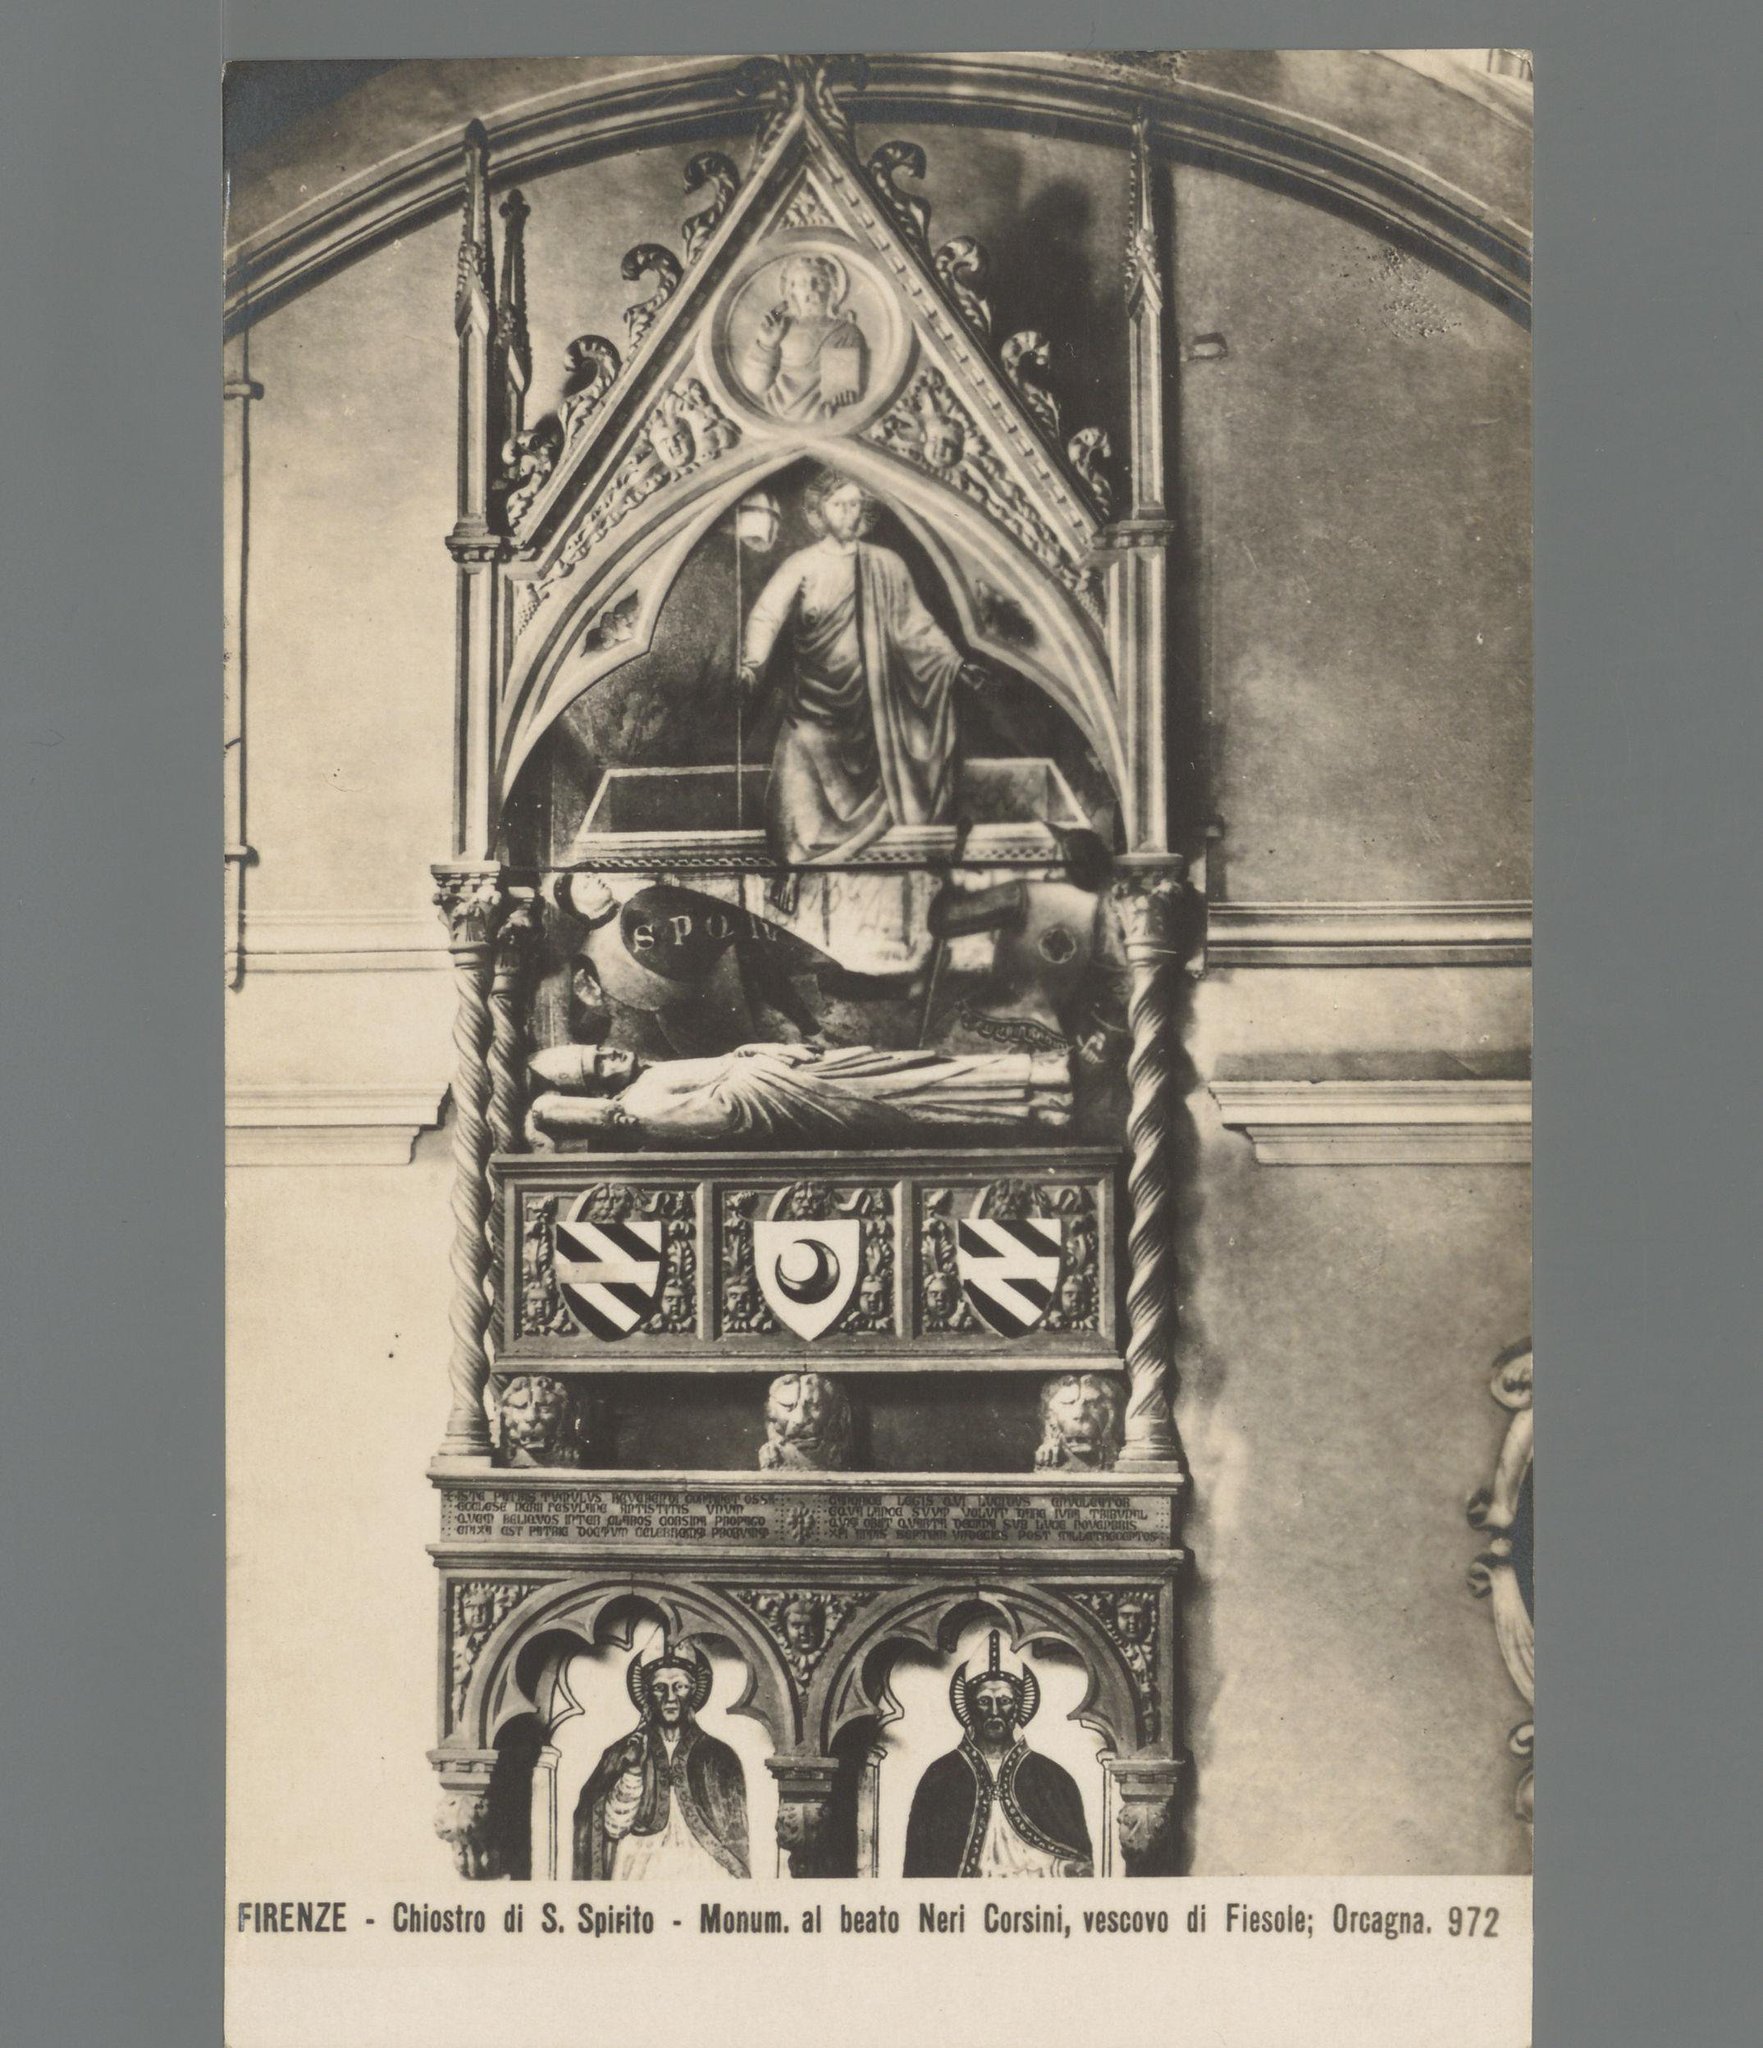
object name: ansichtkaart, prentbriefkaart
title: Firenze. Chiostro di S. Spirito - Monum. al beato Neri Corsini, vescovo di Fiesole; Orcagna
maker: Anonymous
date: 1906-1930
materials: paper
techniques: gelatin silver print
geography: florence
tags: abbey, monastery, convent ~ roman catholic church, statues, paintings, etc. ~ objects of worship in roman religion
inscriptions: collector's mark: ‘AFE v S’